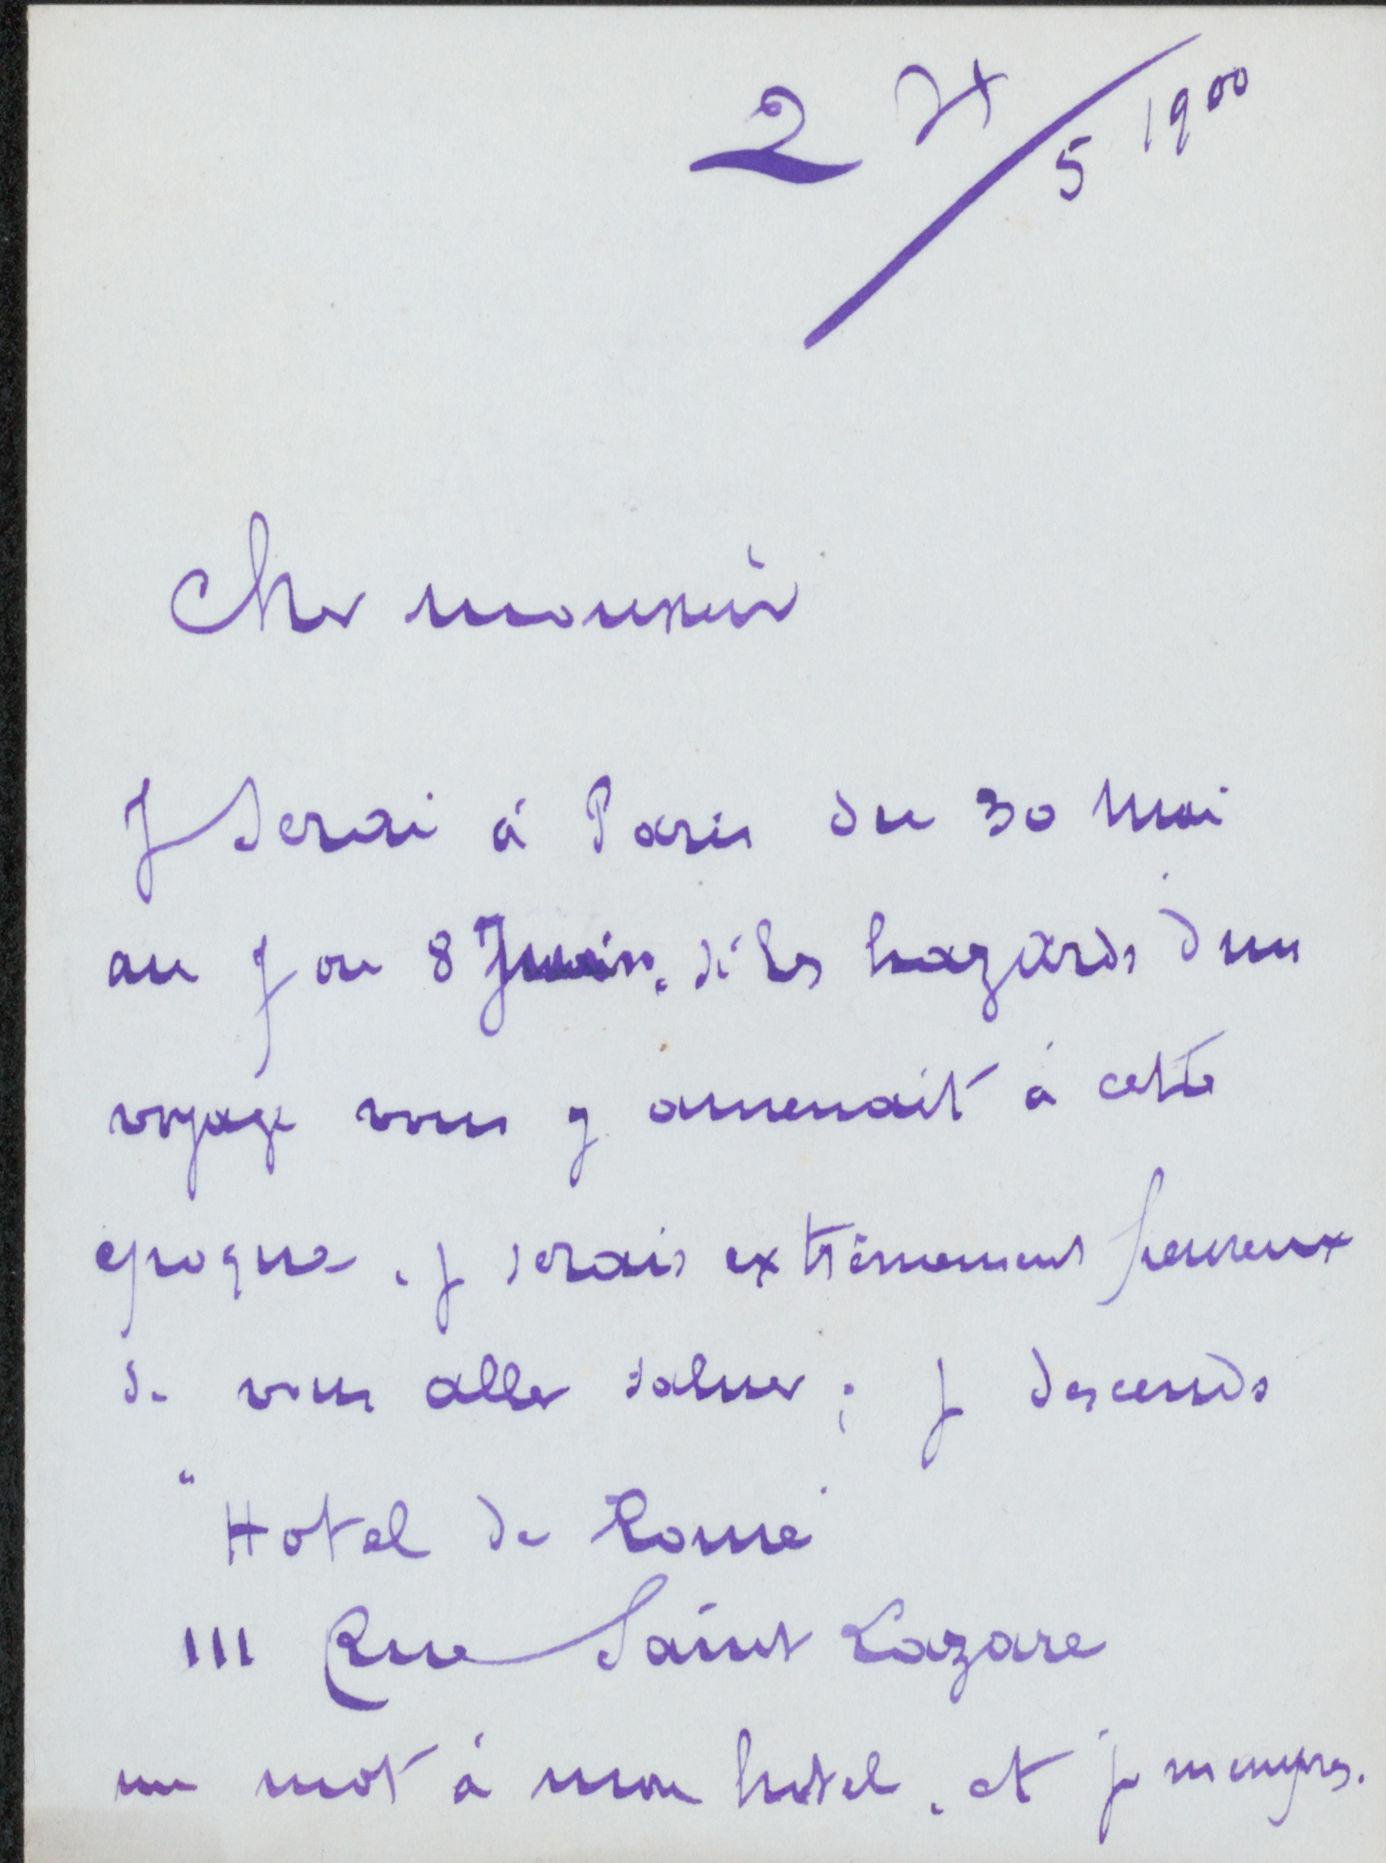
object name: letter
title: Brief aan Philip Zilcken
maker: gustave bourcard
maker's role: verzamelaar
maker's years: 1846-1925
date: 1900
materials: ink, paper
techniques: pen, writing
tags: the hague, painter, draughtsman, philip zilcken, paris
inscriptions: collector's mark: ‘RPK’